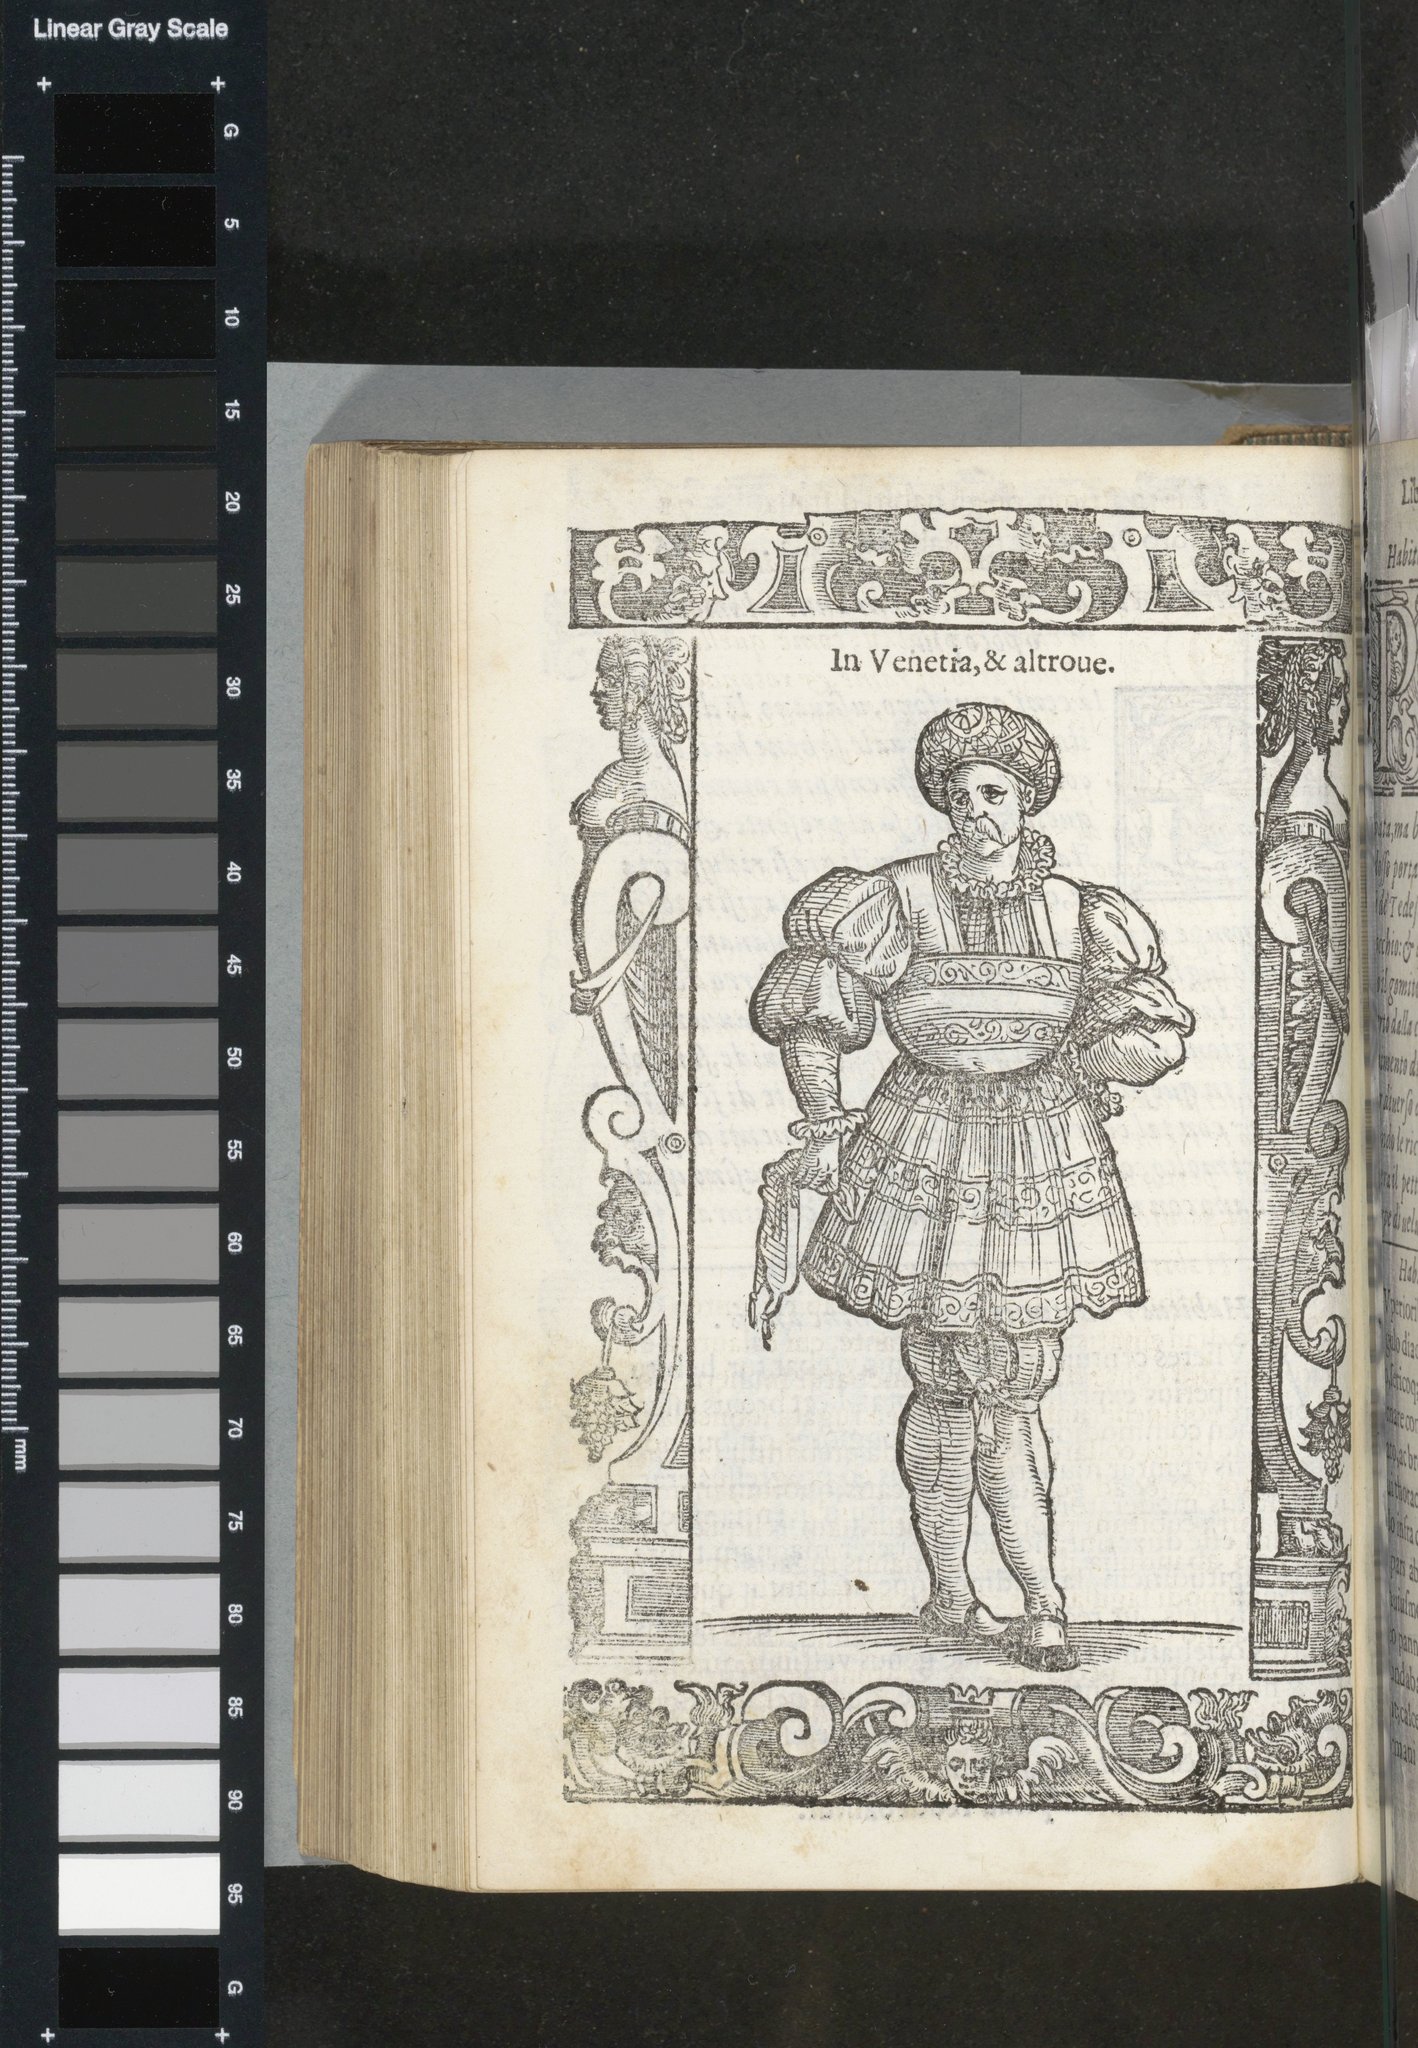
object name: costume print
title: In venetia & altrove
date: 1598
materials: paper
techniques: woodcut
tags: fashion plates